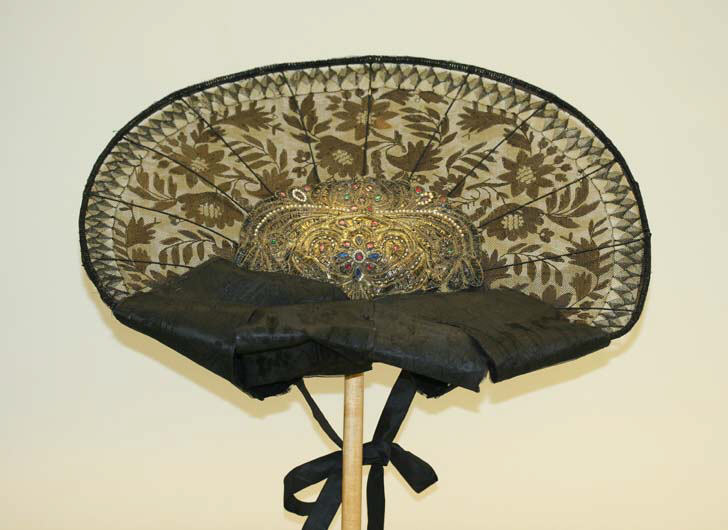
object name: headdress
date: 1801-1900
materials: cotton, glass, metal, silk, thread